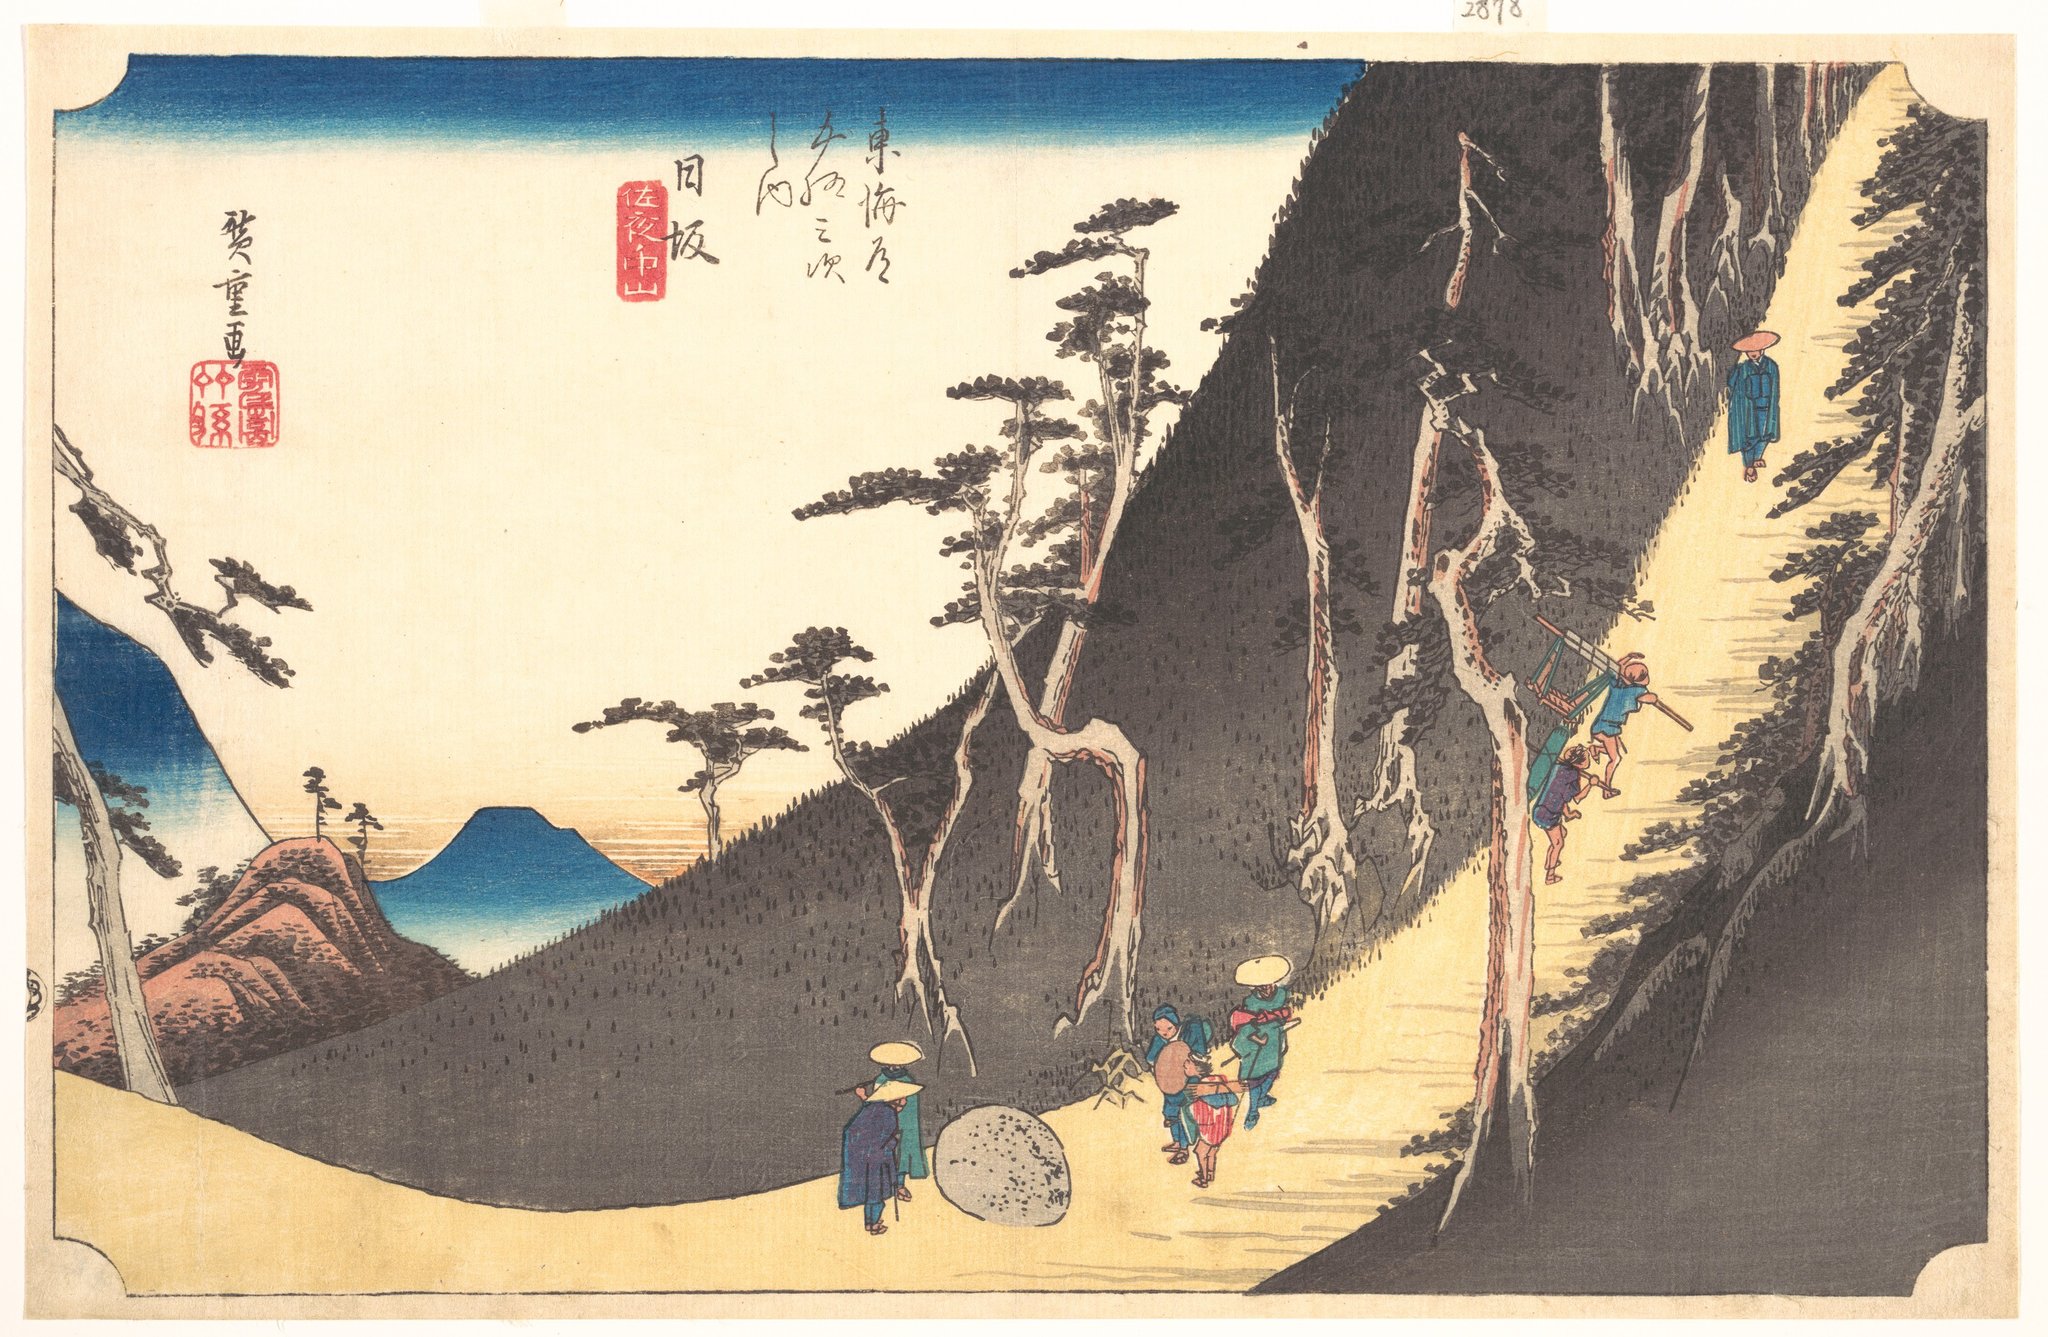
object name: woodblock print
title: Station Twenty-six: Nissaka, Sayo no Nakayama, from the Fifty-three Stations of the Tokaido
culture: japanese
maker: utagawa hiroshige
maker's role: artist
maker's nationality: japanese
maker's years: 1797-1858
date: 1833-1834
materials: ink, paper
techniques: woodblock print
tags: human figures,landscapes,trees